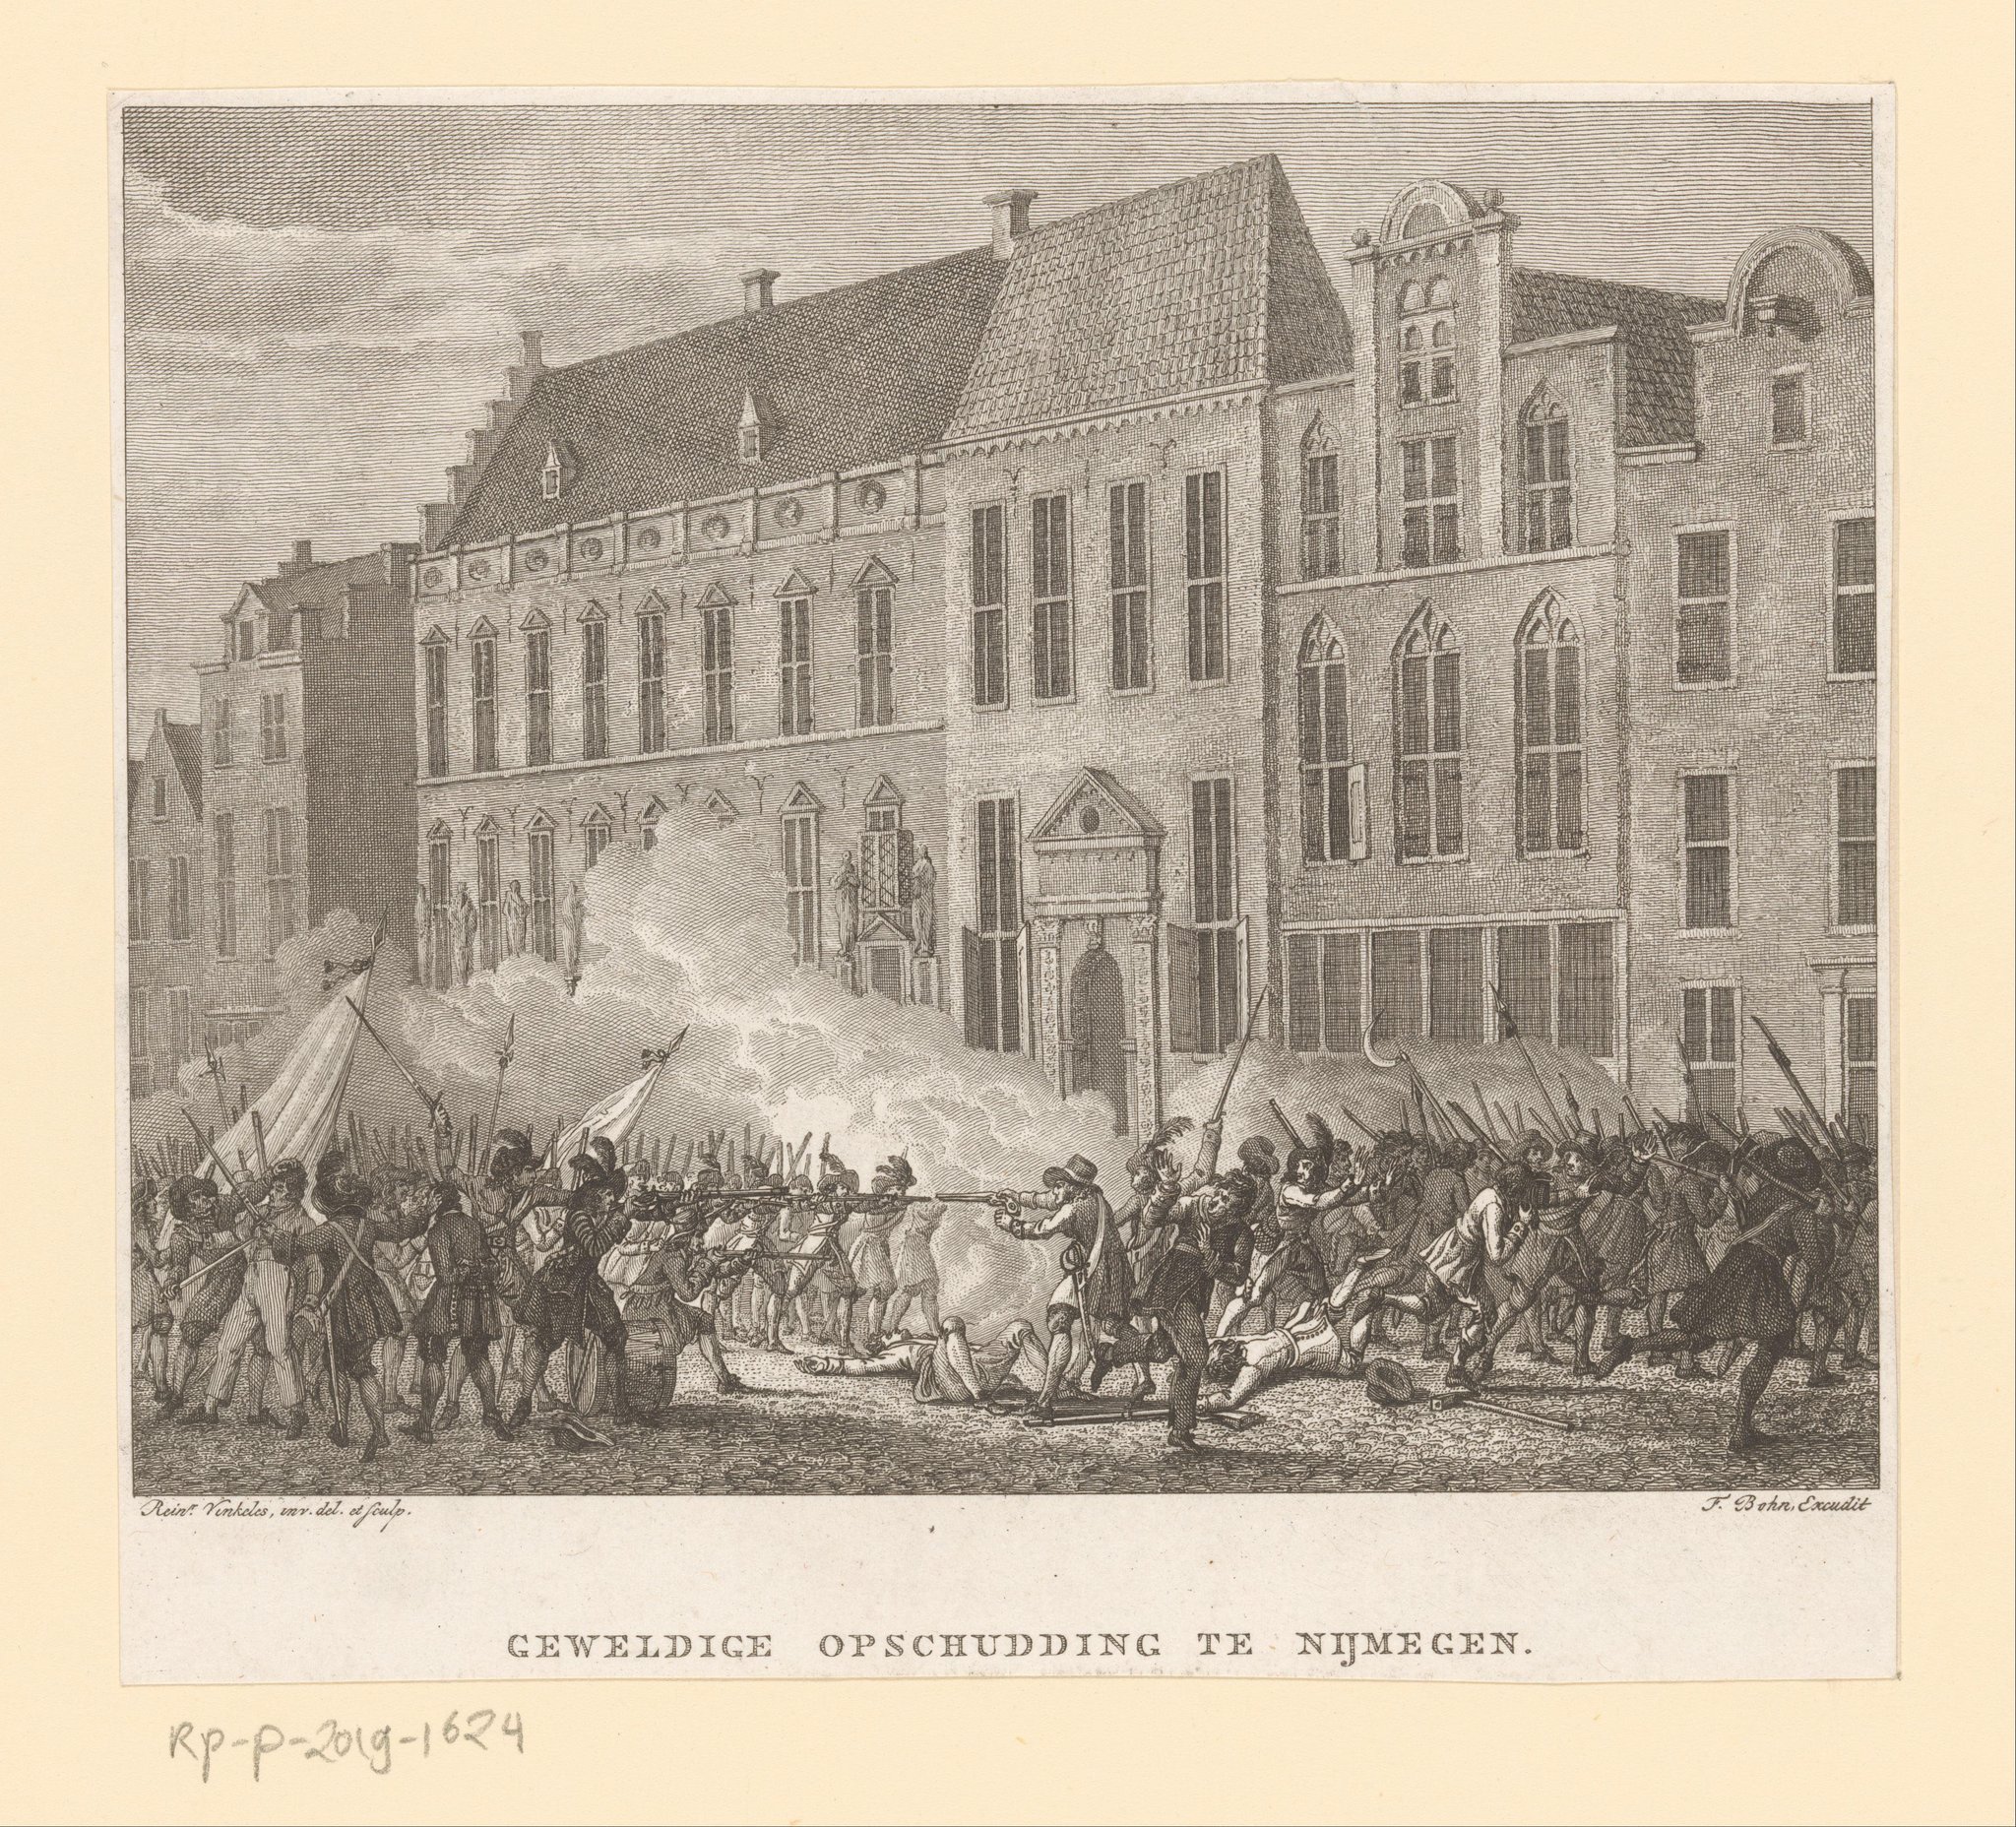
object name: print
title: Geweldige opschudding te Nijmegen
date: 1801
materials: paper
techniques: etching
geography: haarlem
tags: violent death by firearms, street-fights, riots, nijmegen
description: Straatgevechten naar aanleiding van de magistraatsverandering te Nijmegen, 2 januari 1703. Groepen soldaten en burgers schieten naar elkaar op straat voor het stadhuis. Strijd tussen de aanhangers van de 'Oude Plooi' (de zittende regenten) en de 'Nieuwe Plooi' (gemeenlieden, nieuwe regenten) gesteund door de Maasschippers.